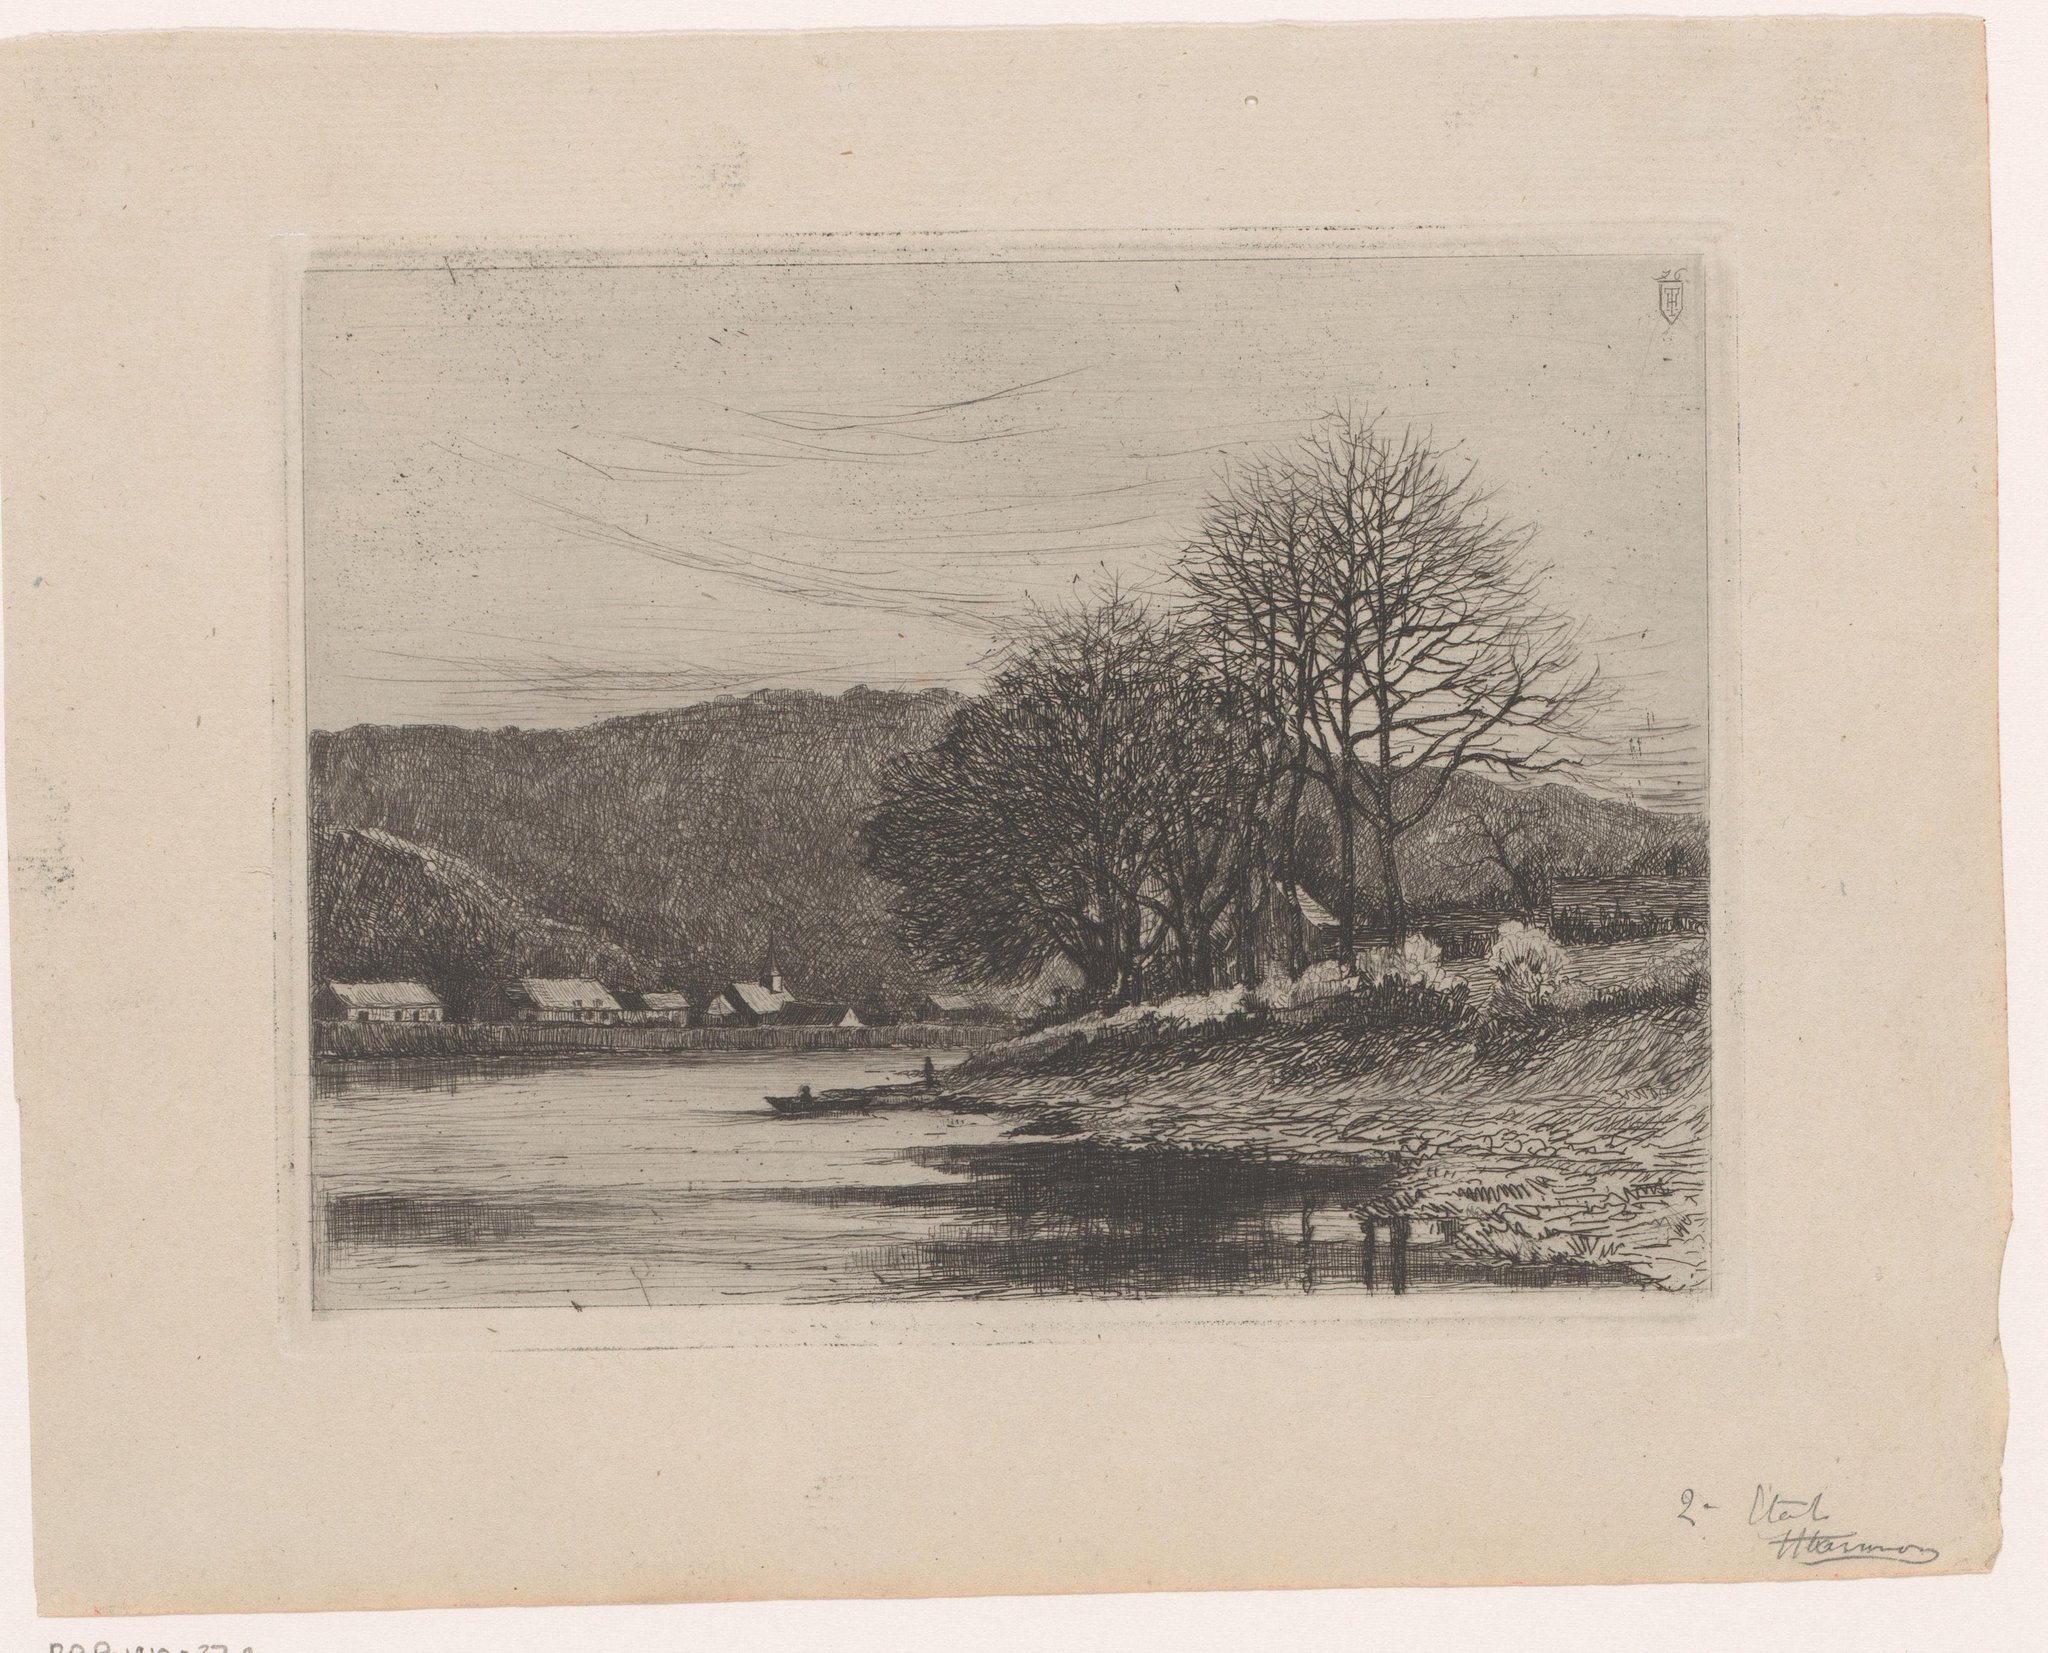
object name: print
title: Riviergezicht met bergen en bomengroep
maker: theodoor hannon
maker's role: print maker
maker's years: 1851-1917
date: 1876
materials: paper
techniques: etching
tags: prospect of village, silhouette of village, river, mountains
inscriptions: inscription: ‘2e Etat’, collector's mark: Lugt 2228